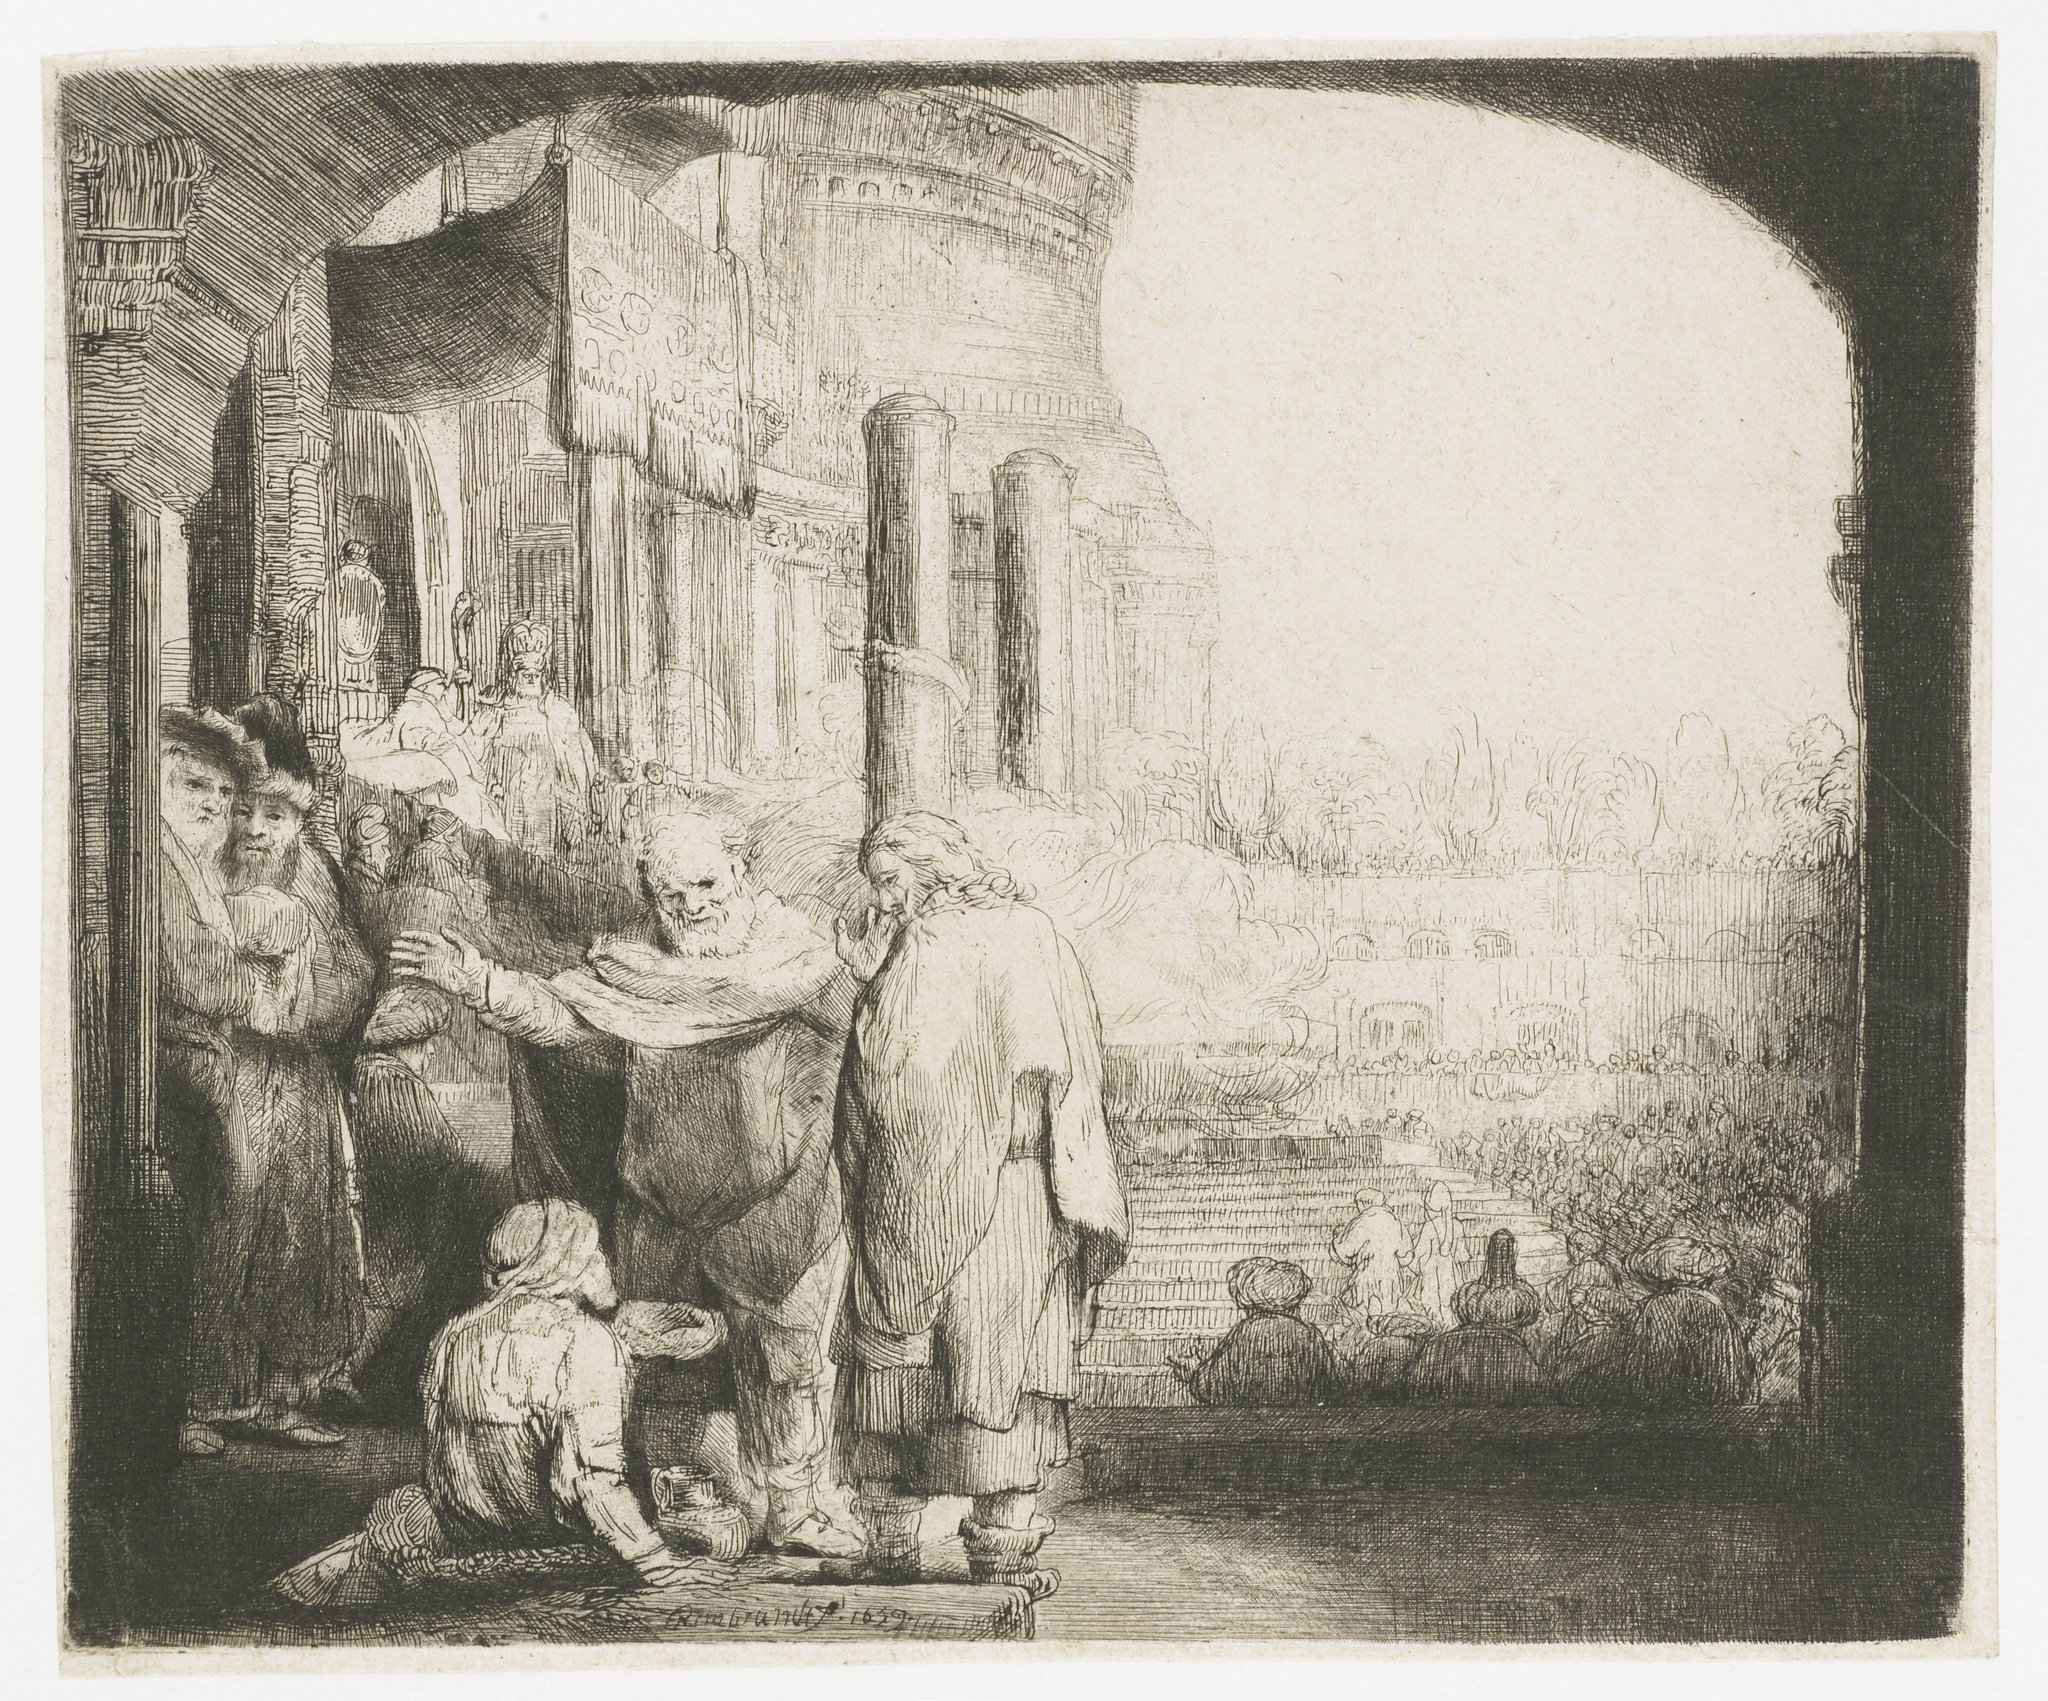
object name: print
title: Peter and John heal a paralyzed man at the temple gate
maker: rembrandt van rijn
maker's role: draughtsman, painter, print maker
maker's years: 1606-1669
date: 1659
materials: paper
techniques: drypoint, etching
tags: healing of a lame beggar at the beautiful gate of the temple by peter and john (acts 3 - 4:31), disabilities, deformations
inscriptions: signature and date: ‘Rembrandt f. 1659’, collector's mark: Lugt 2228, collector's mark: Lugt 2760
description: De voorstelling is gebaseerd op de tekst uit Handelingen 3:4-31.